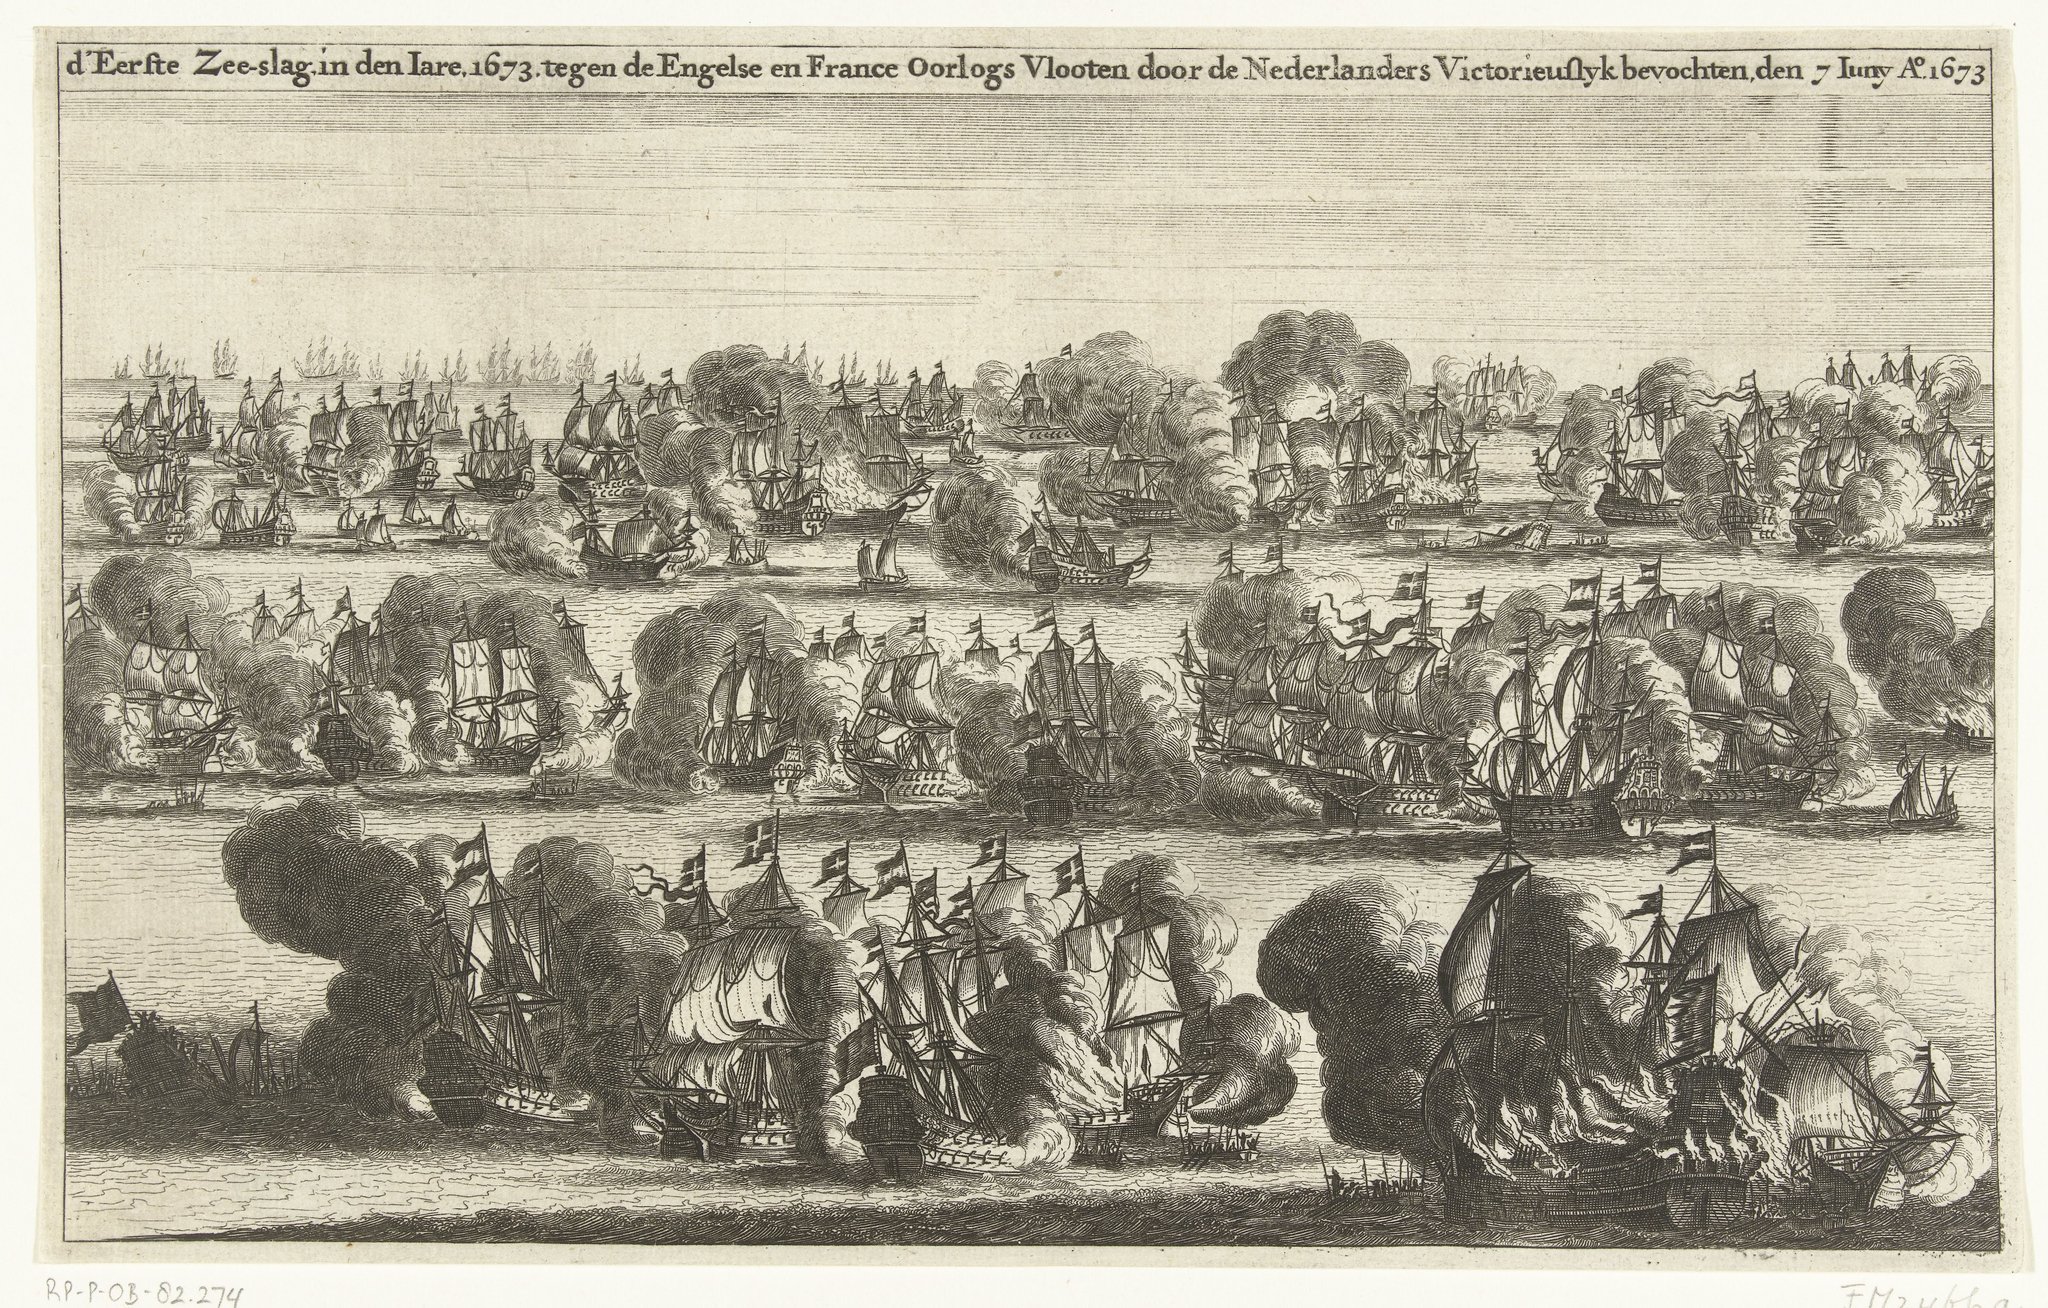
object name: history print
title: Zeeslag op Schoonevelt, 7 juni 1673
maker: Anonymous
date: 1674-1676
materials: paper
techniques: etching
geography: northern netherlands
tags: london, print maker, draughtsman, prinz ruprecht, flushing, michiel adriaenszoon de ruyter, rotterdam, cornelis tromp, battle (+ naval force), first battle of schooneveld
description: De zeeslag voor de Zeeuwse kust op de vlakte van Schoonevelt op 7 juni 1673 tussen de vloot van de Republiek onder Michiel Adriaenszoon de Ruyter en de gecombineerde Engels-Franse vloot onder Prins Rupert en graaf Jean d'Estrées.